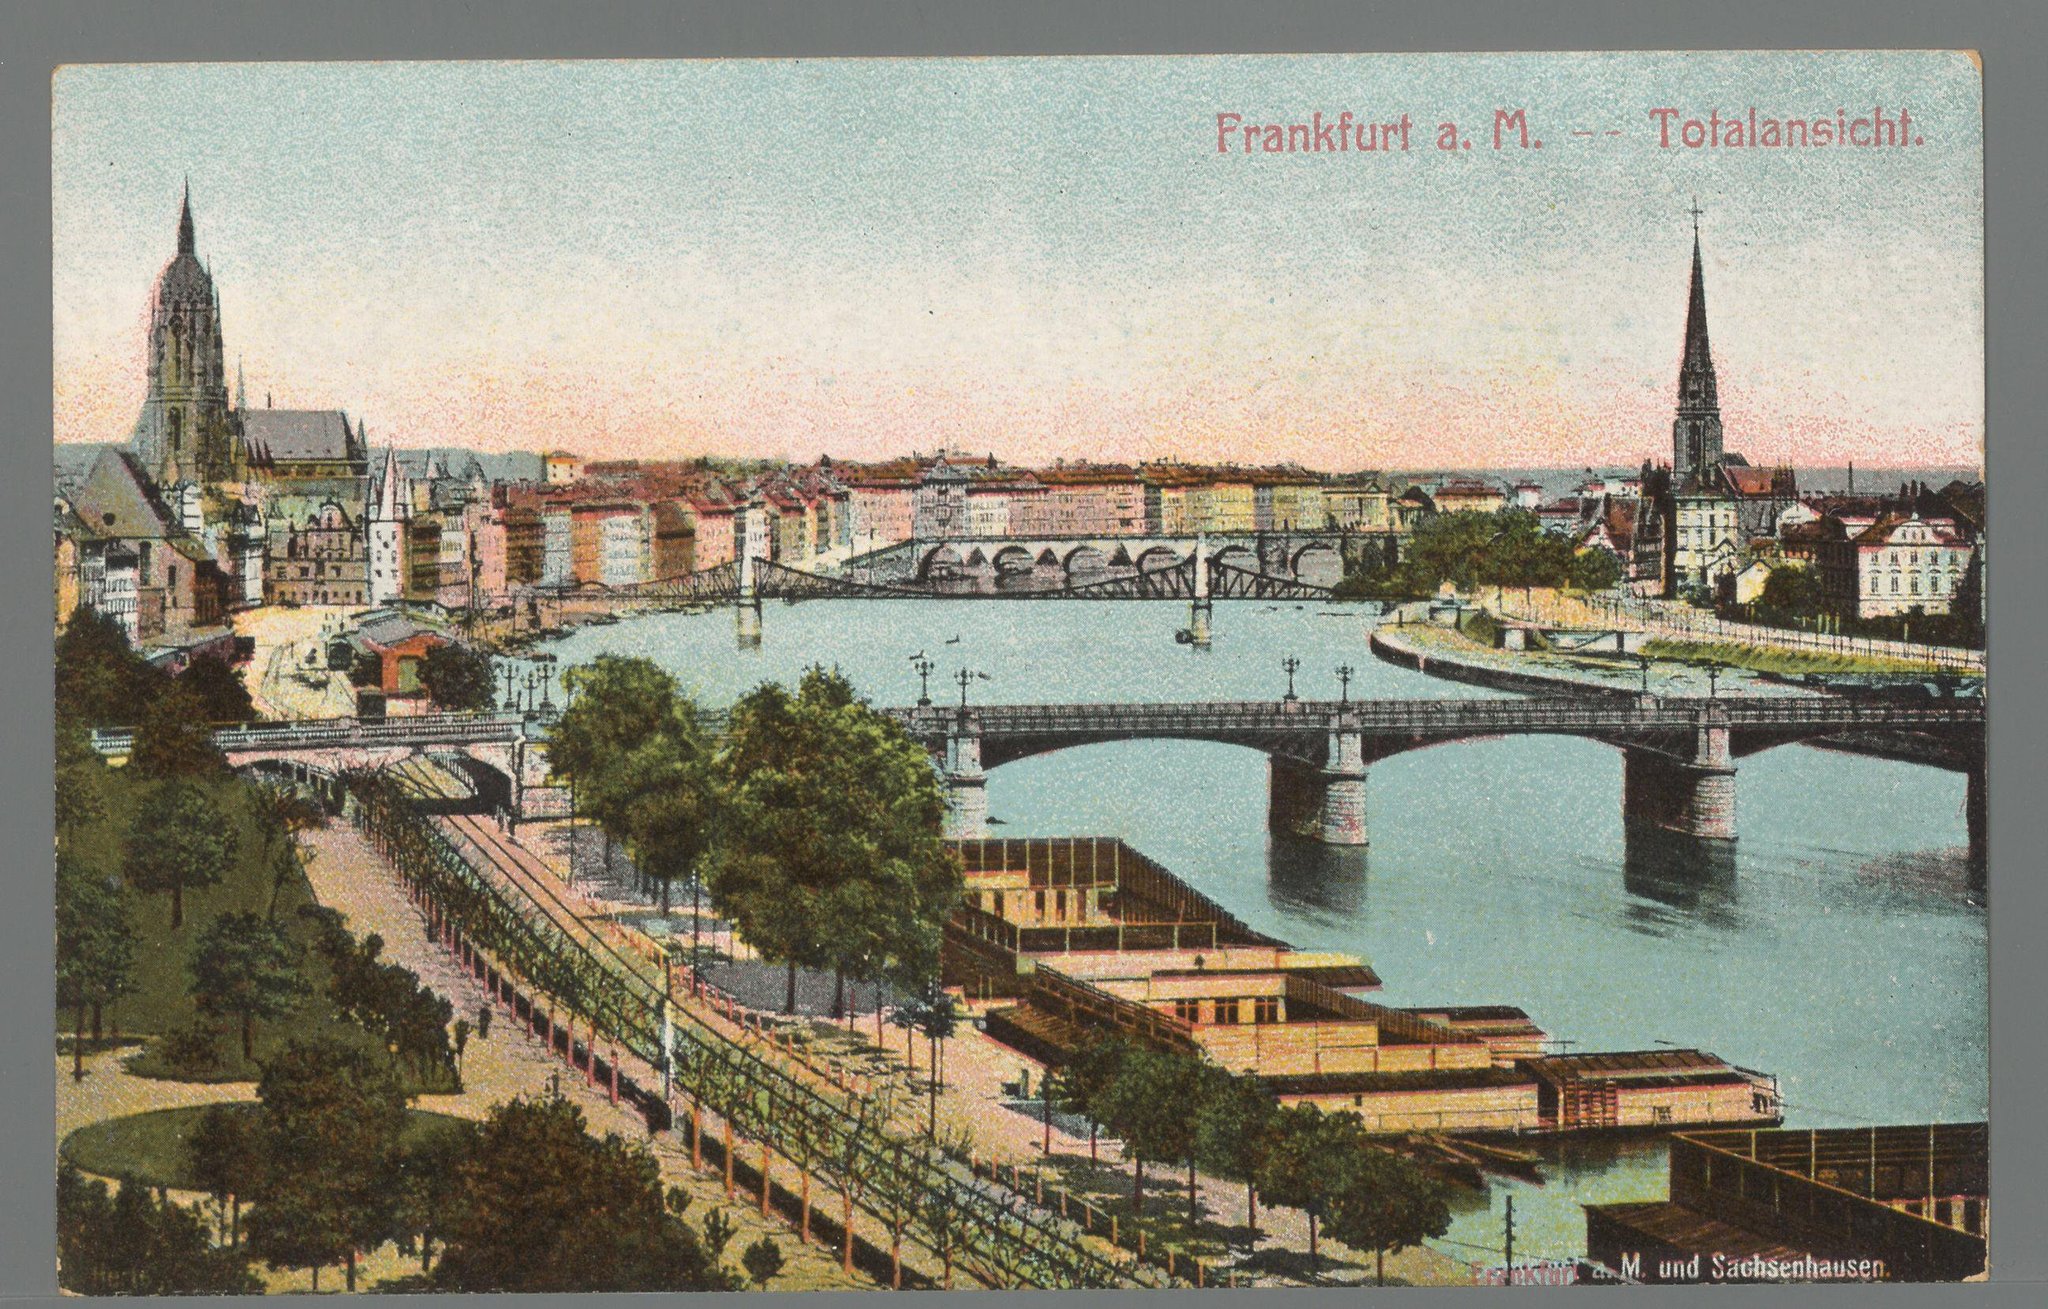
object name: photomechanical print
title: Frankfurt a. M. - Totalansicht. Frankfurt a. M. und Sachsenhausen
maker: Anonymous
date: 1905-1908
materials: cardboard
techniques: lithograph, writing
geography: frankfurt am main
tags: city-view, and landscape with man-made constructions, church (exterior), canals, waters (in city), bridge in city across river, canal, etc.